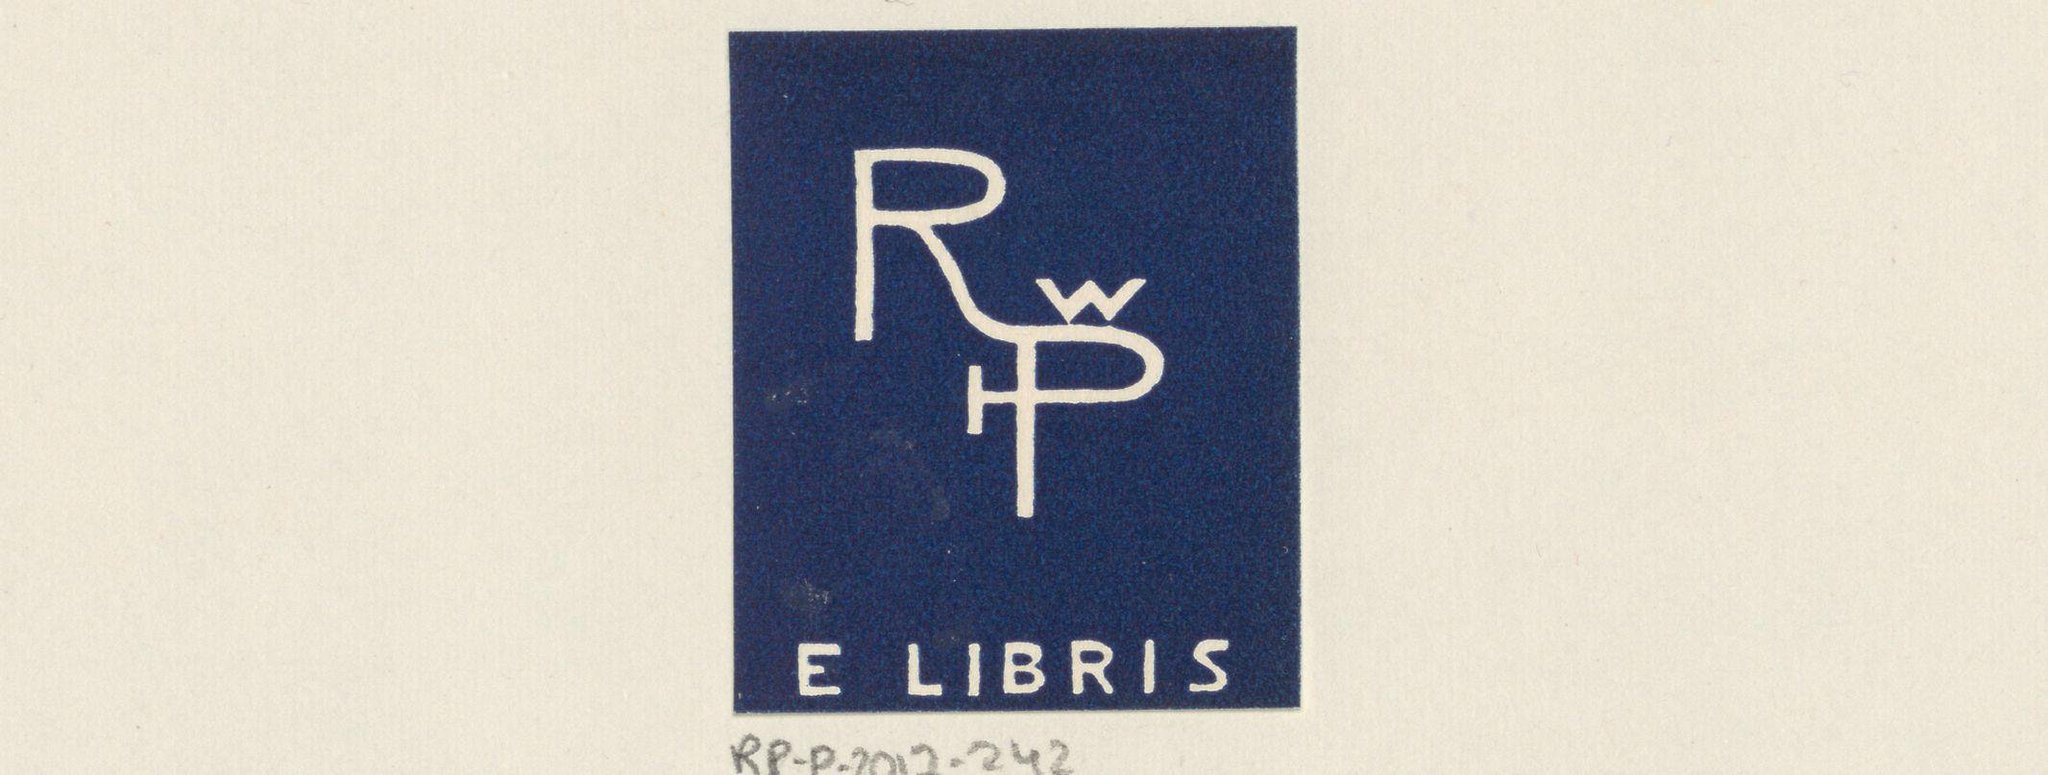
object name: bookplate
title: Ex libris van R.w.h.P.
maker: Anonymous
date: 1933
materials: paper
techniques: printing block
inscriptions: inscription: ‘RwhP ites (?) / 1933’